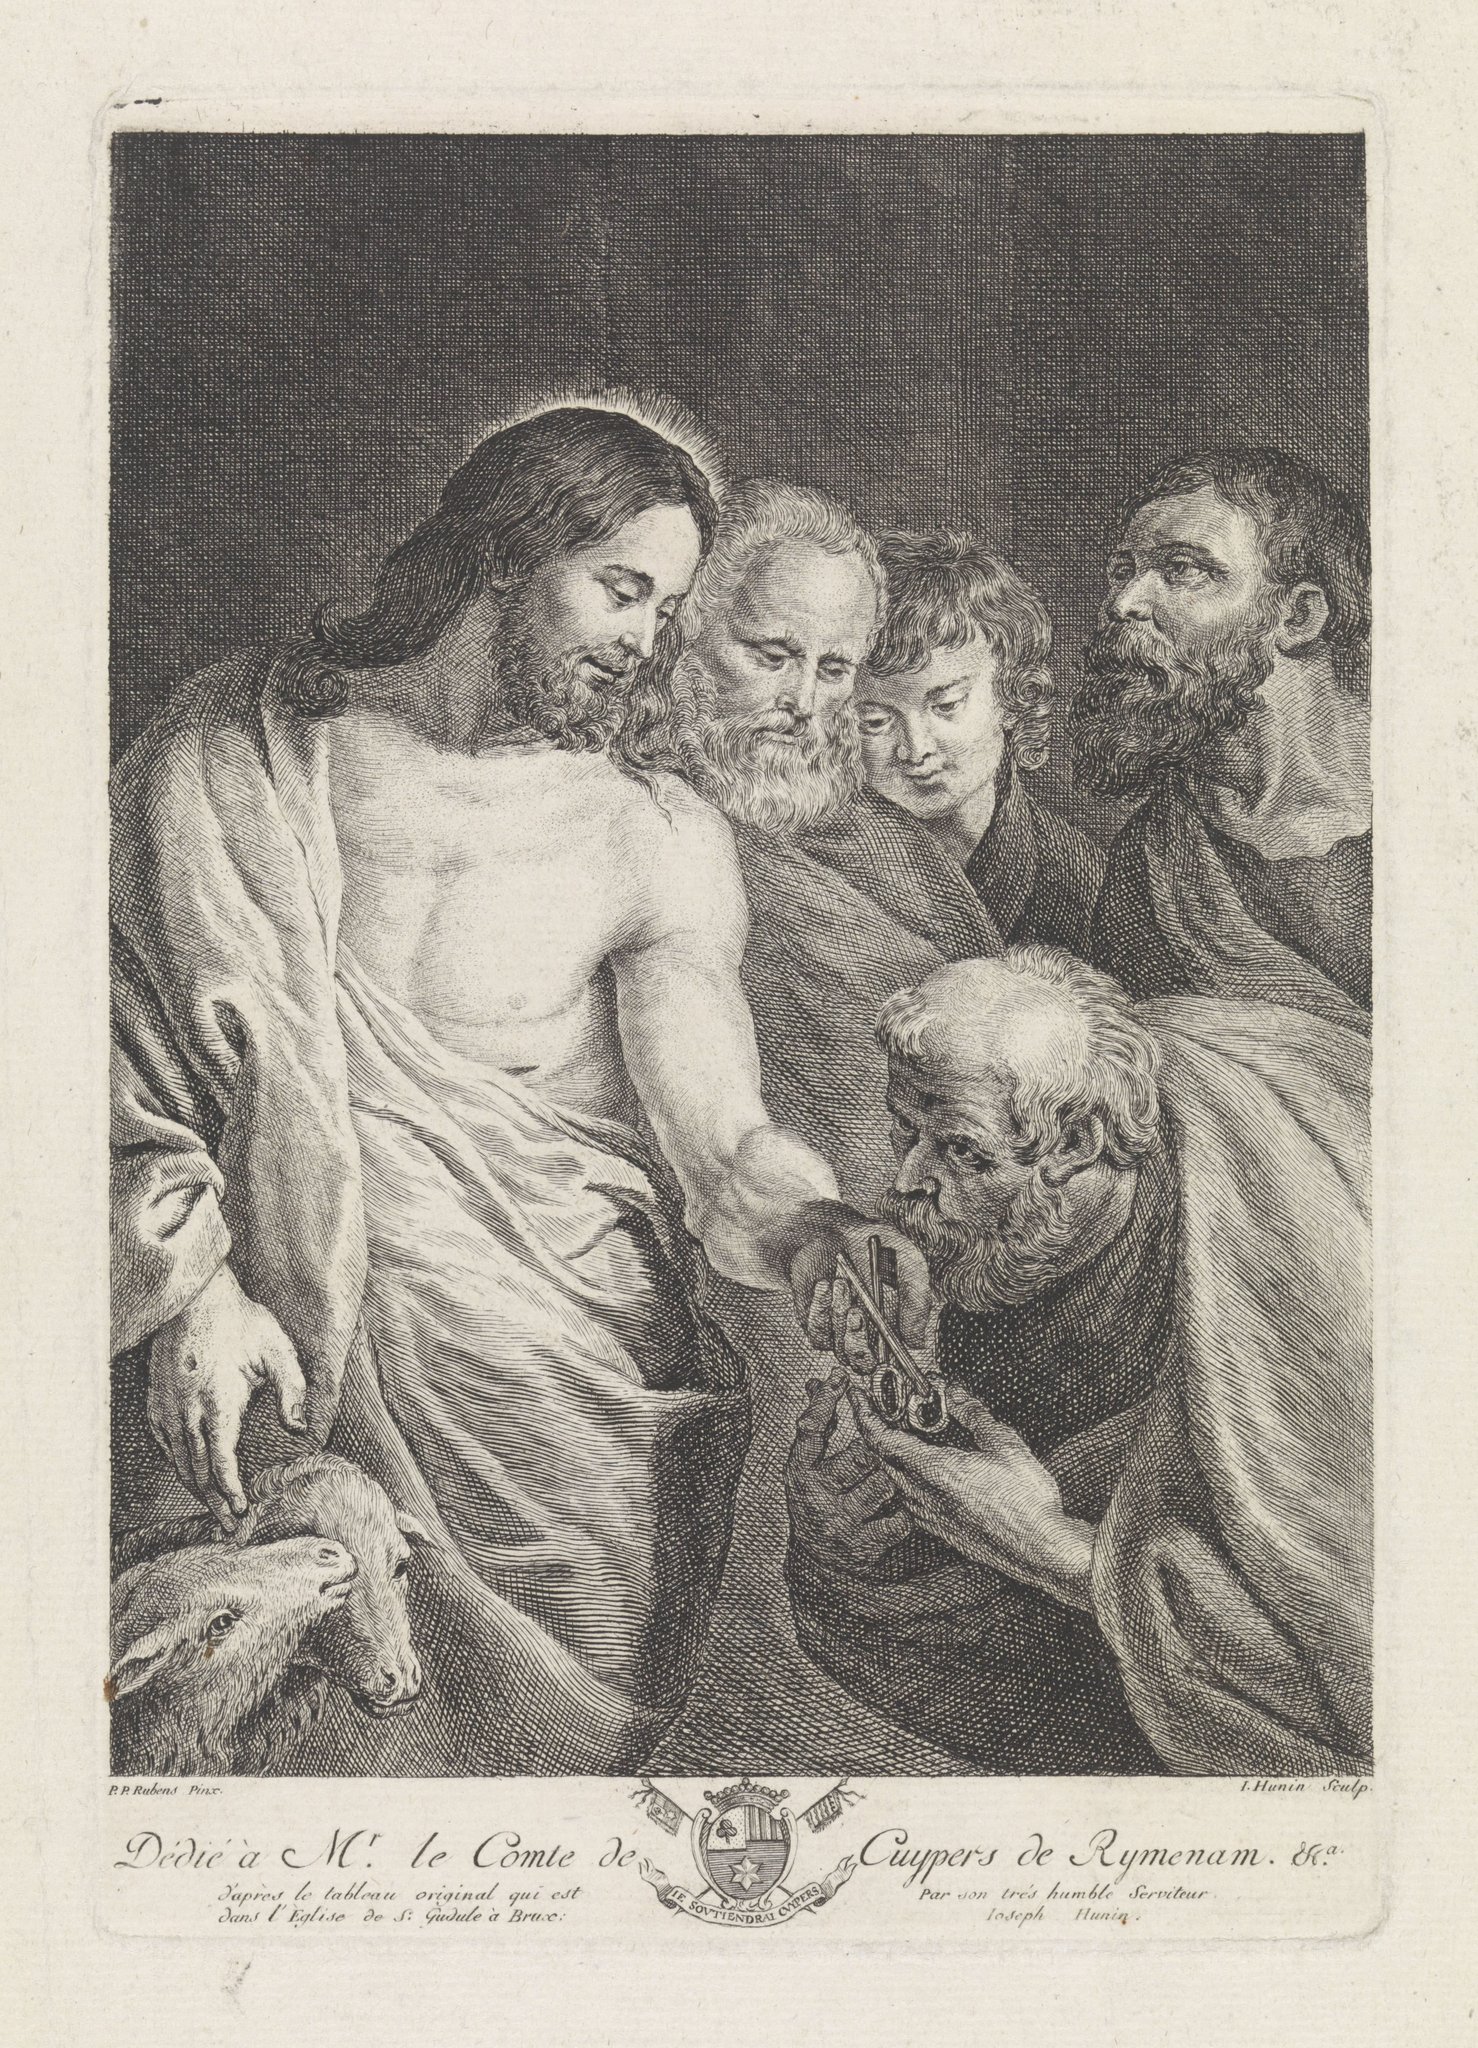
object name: print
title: Petrus ontvangt de sleutels van Christus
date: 1780-1851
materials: paper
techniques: engraving, etching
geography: mechelen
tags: christ gives the keys of heaven to peter, mission of peter ('pasce oves meas'): christ pointing to a lamb, peter perhaps with keys in his hands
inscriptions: collector's mark: Lugt 2228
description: Petrus knielt voor de opgestane Christus en ontvangt van hem de sleutels. Links twee schapen, die verwijzen naar de opdracht, die Christus na zijn dood bij zijn verschijning aan Petrus gaf: 'Weid mijn lammeren' (Joh. 21:15-17). Drie discipelen kijken toe.